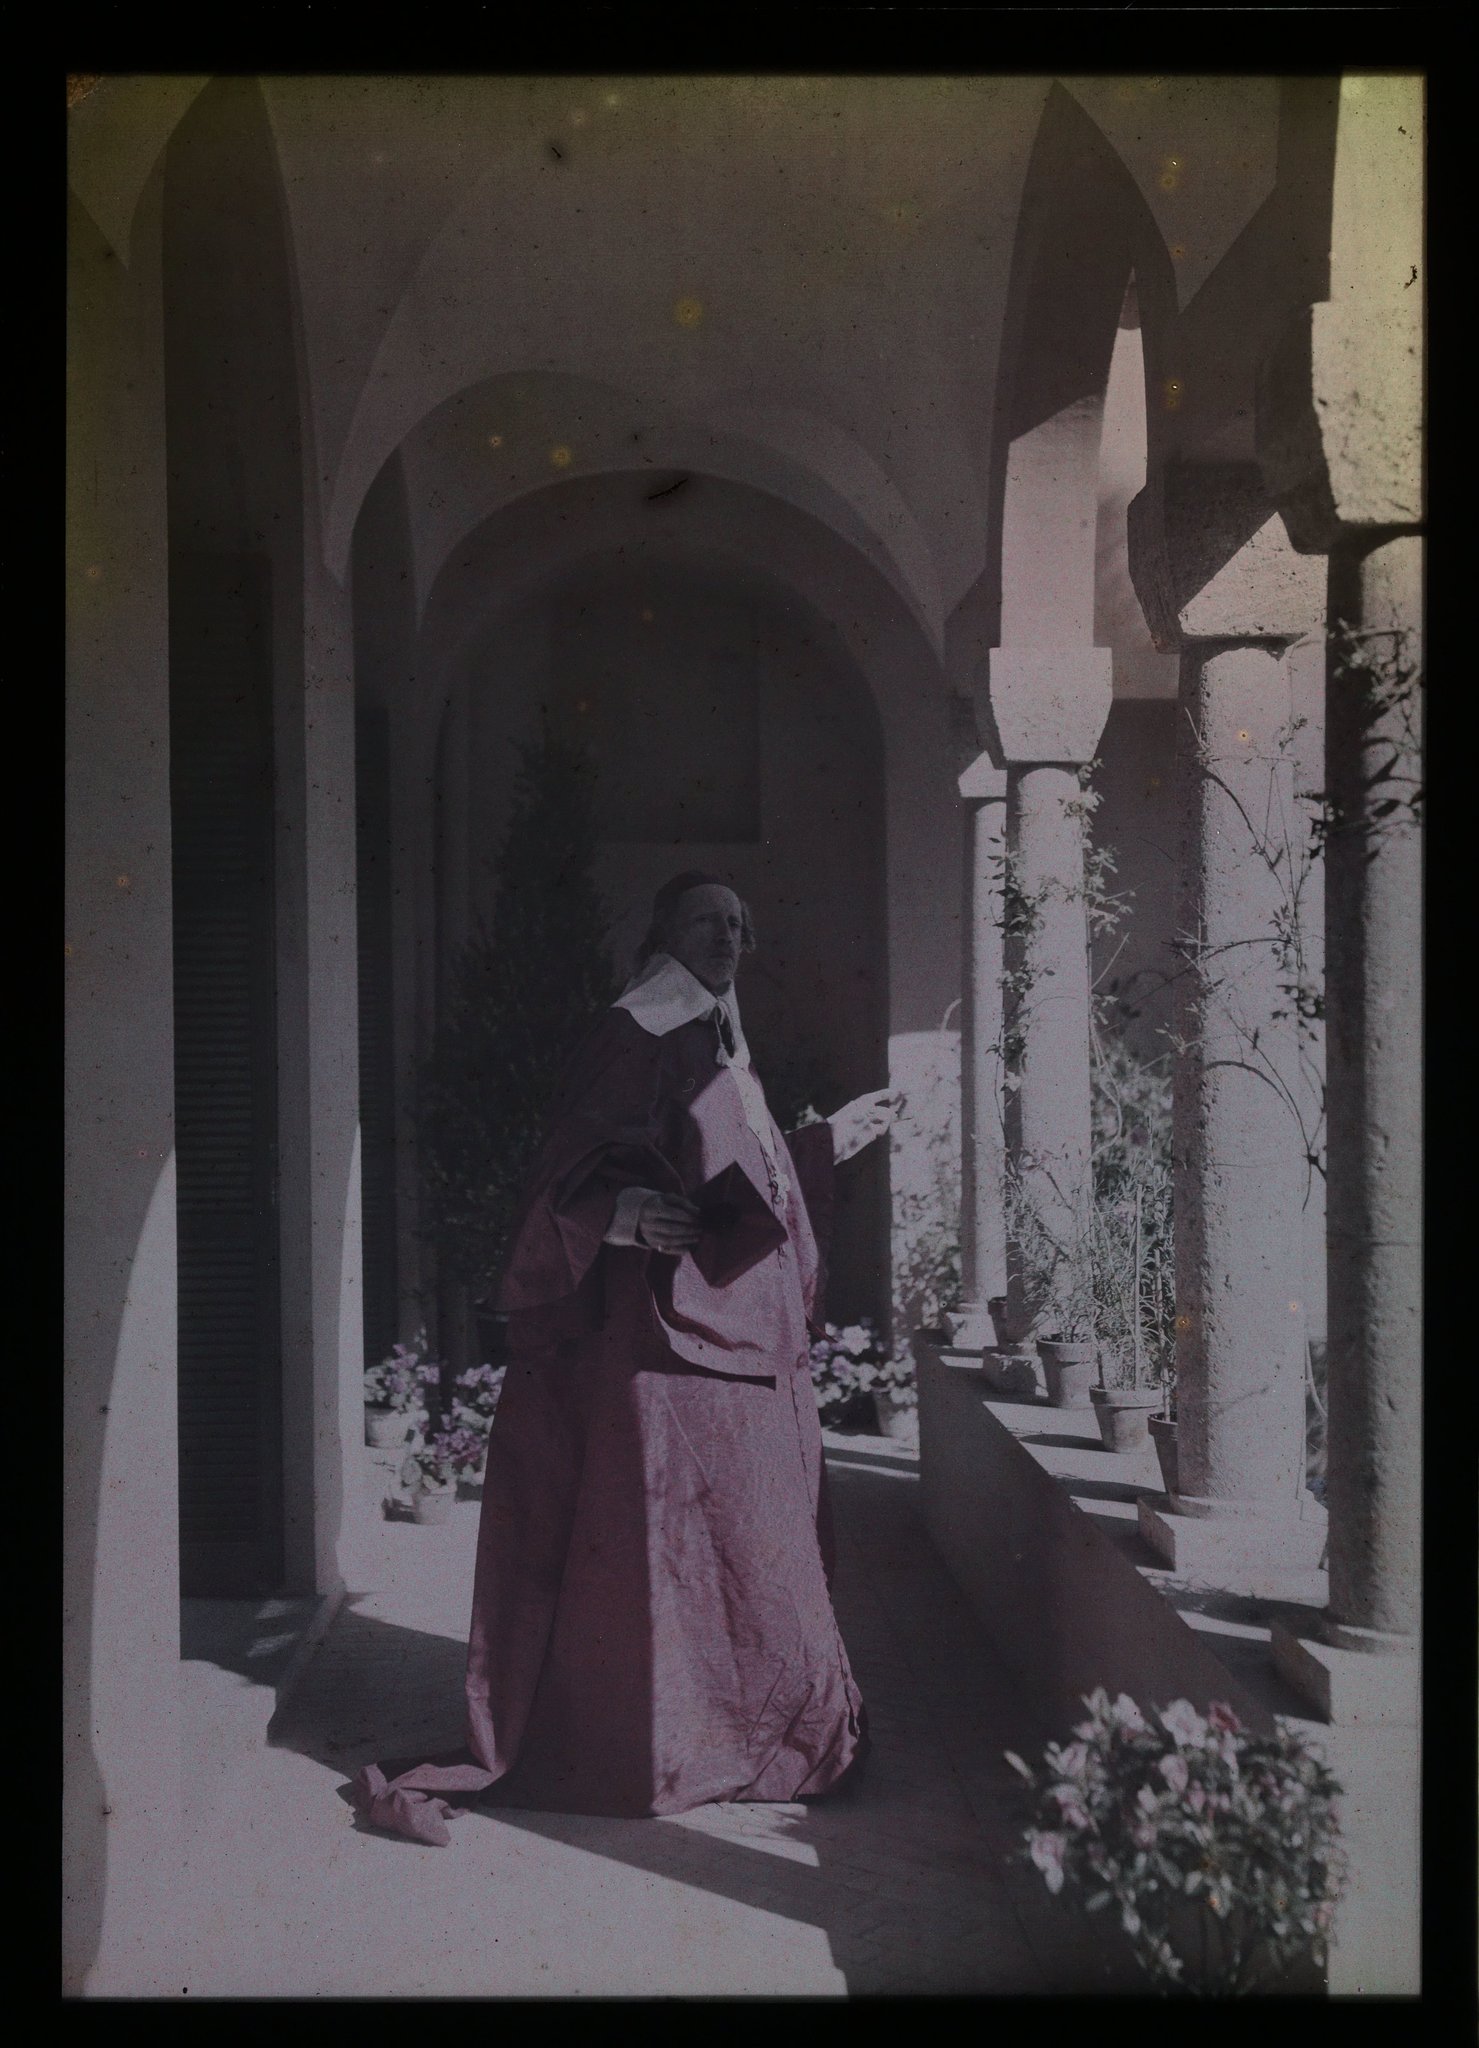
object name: photograph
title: Man gekleed in roze kleding (geestelijke?) staand in een omgang met zuilen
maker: Anonymous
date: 1910-1940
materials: glass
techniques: autochrome process